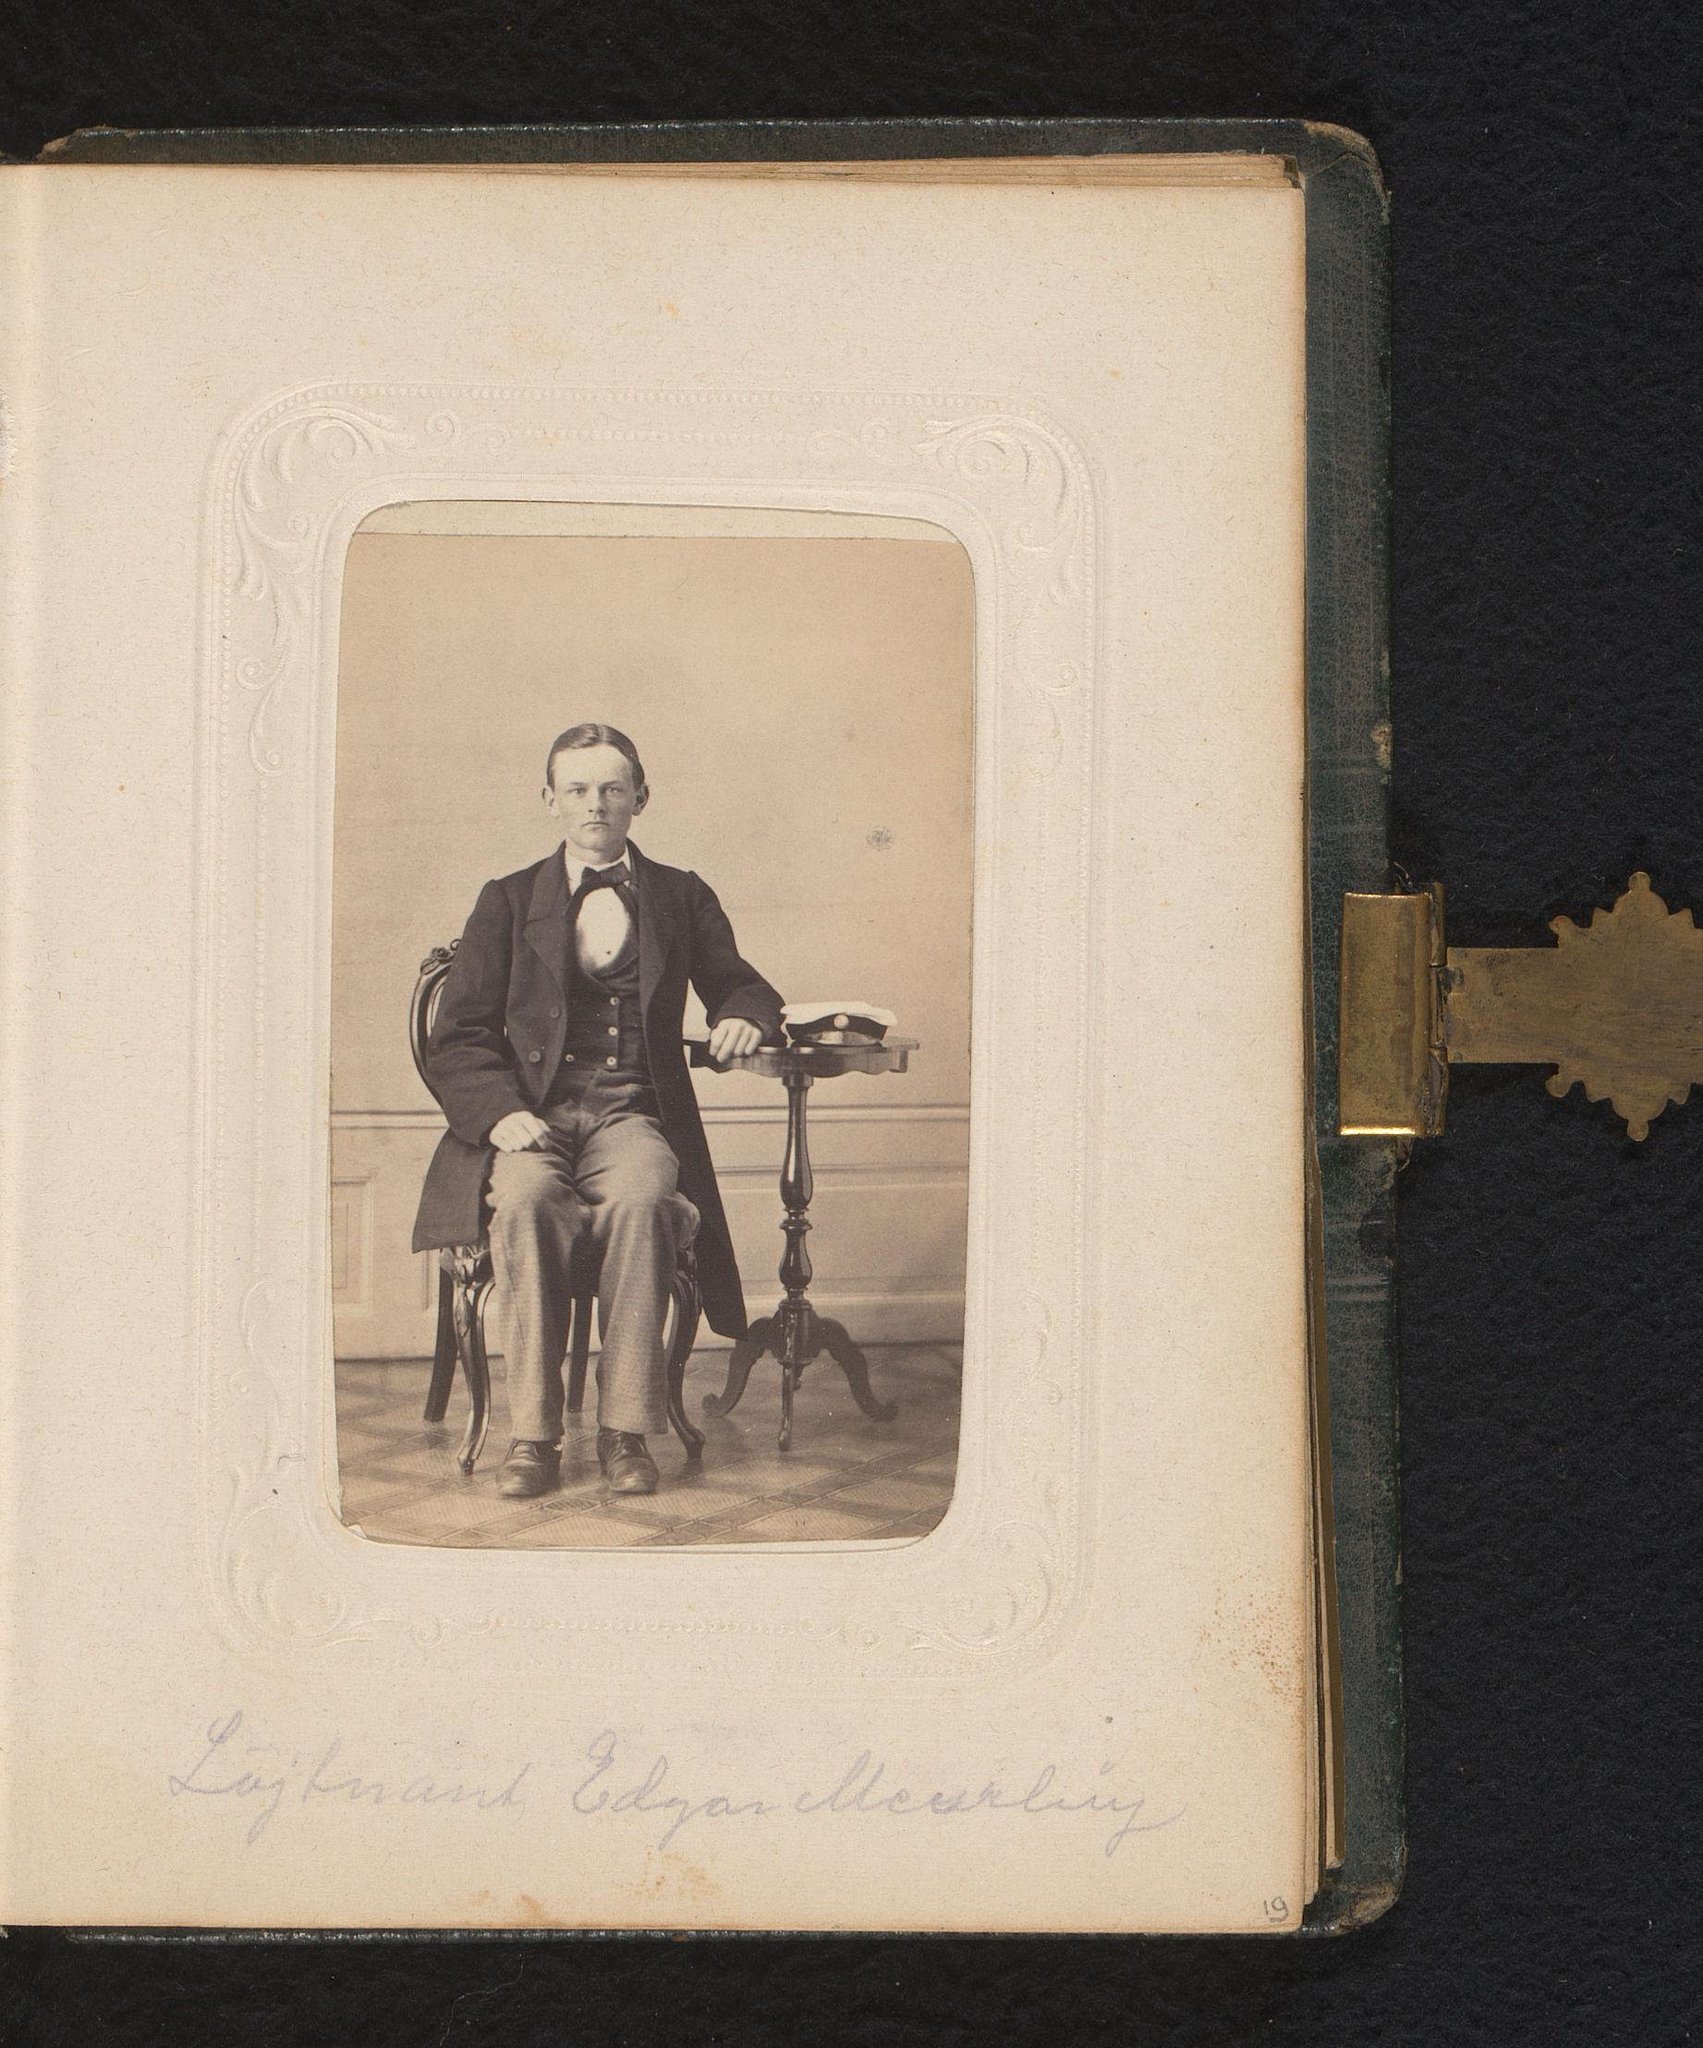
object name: photograph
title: Portret van een zittende jonge man, aangeduid als Edgar Meurling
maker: landén larsson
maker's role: fotograaf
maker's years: 1866-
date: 1860-1900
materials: cardboard, photographic support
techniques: albumen print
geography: amal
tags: sitting figure, historical persons, youth, adolescent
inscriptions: name: ‘Edgar Meurling’, inscription: ‘LAURA LARSSON'S/ PHOTOGRAFISKA ATELIER/ ÅMÅL’, name: ‘Löjtnant Edgar Meurling’, annotation: ‘Löjtnant Edagr Meurling’